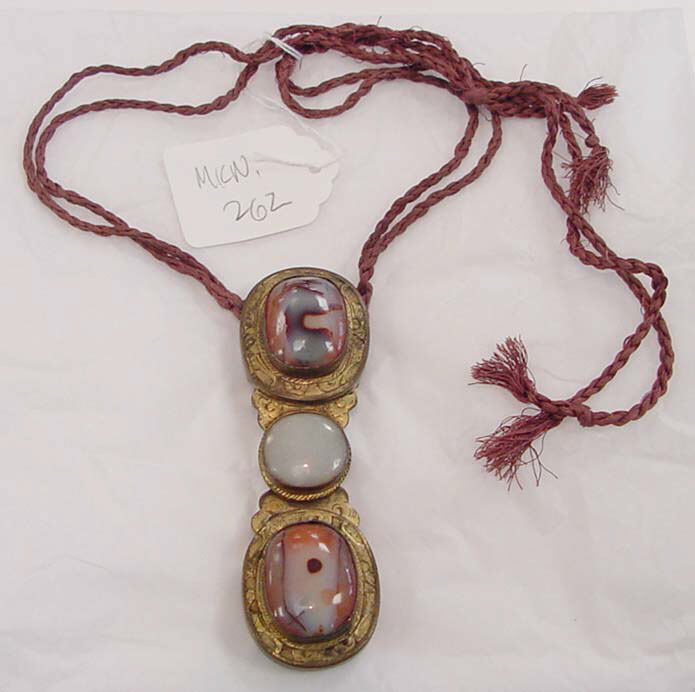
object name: belt buckle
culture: chinese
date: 1735-1796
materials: copper, silk, stone